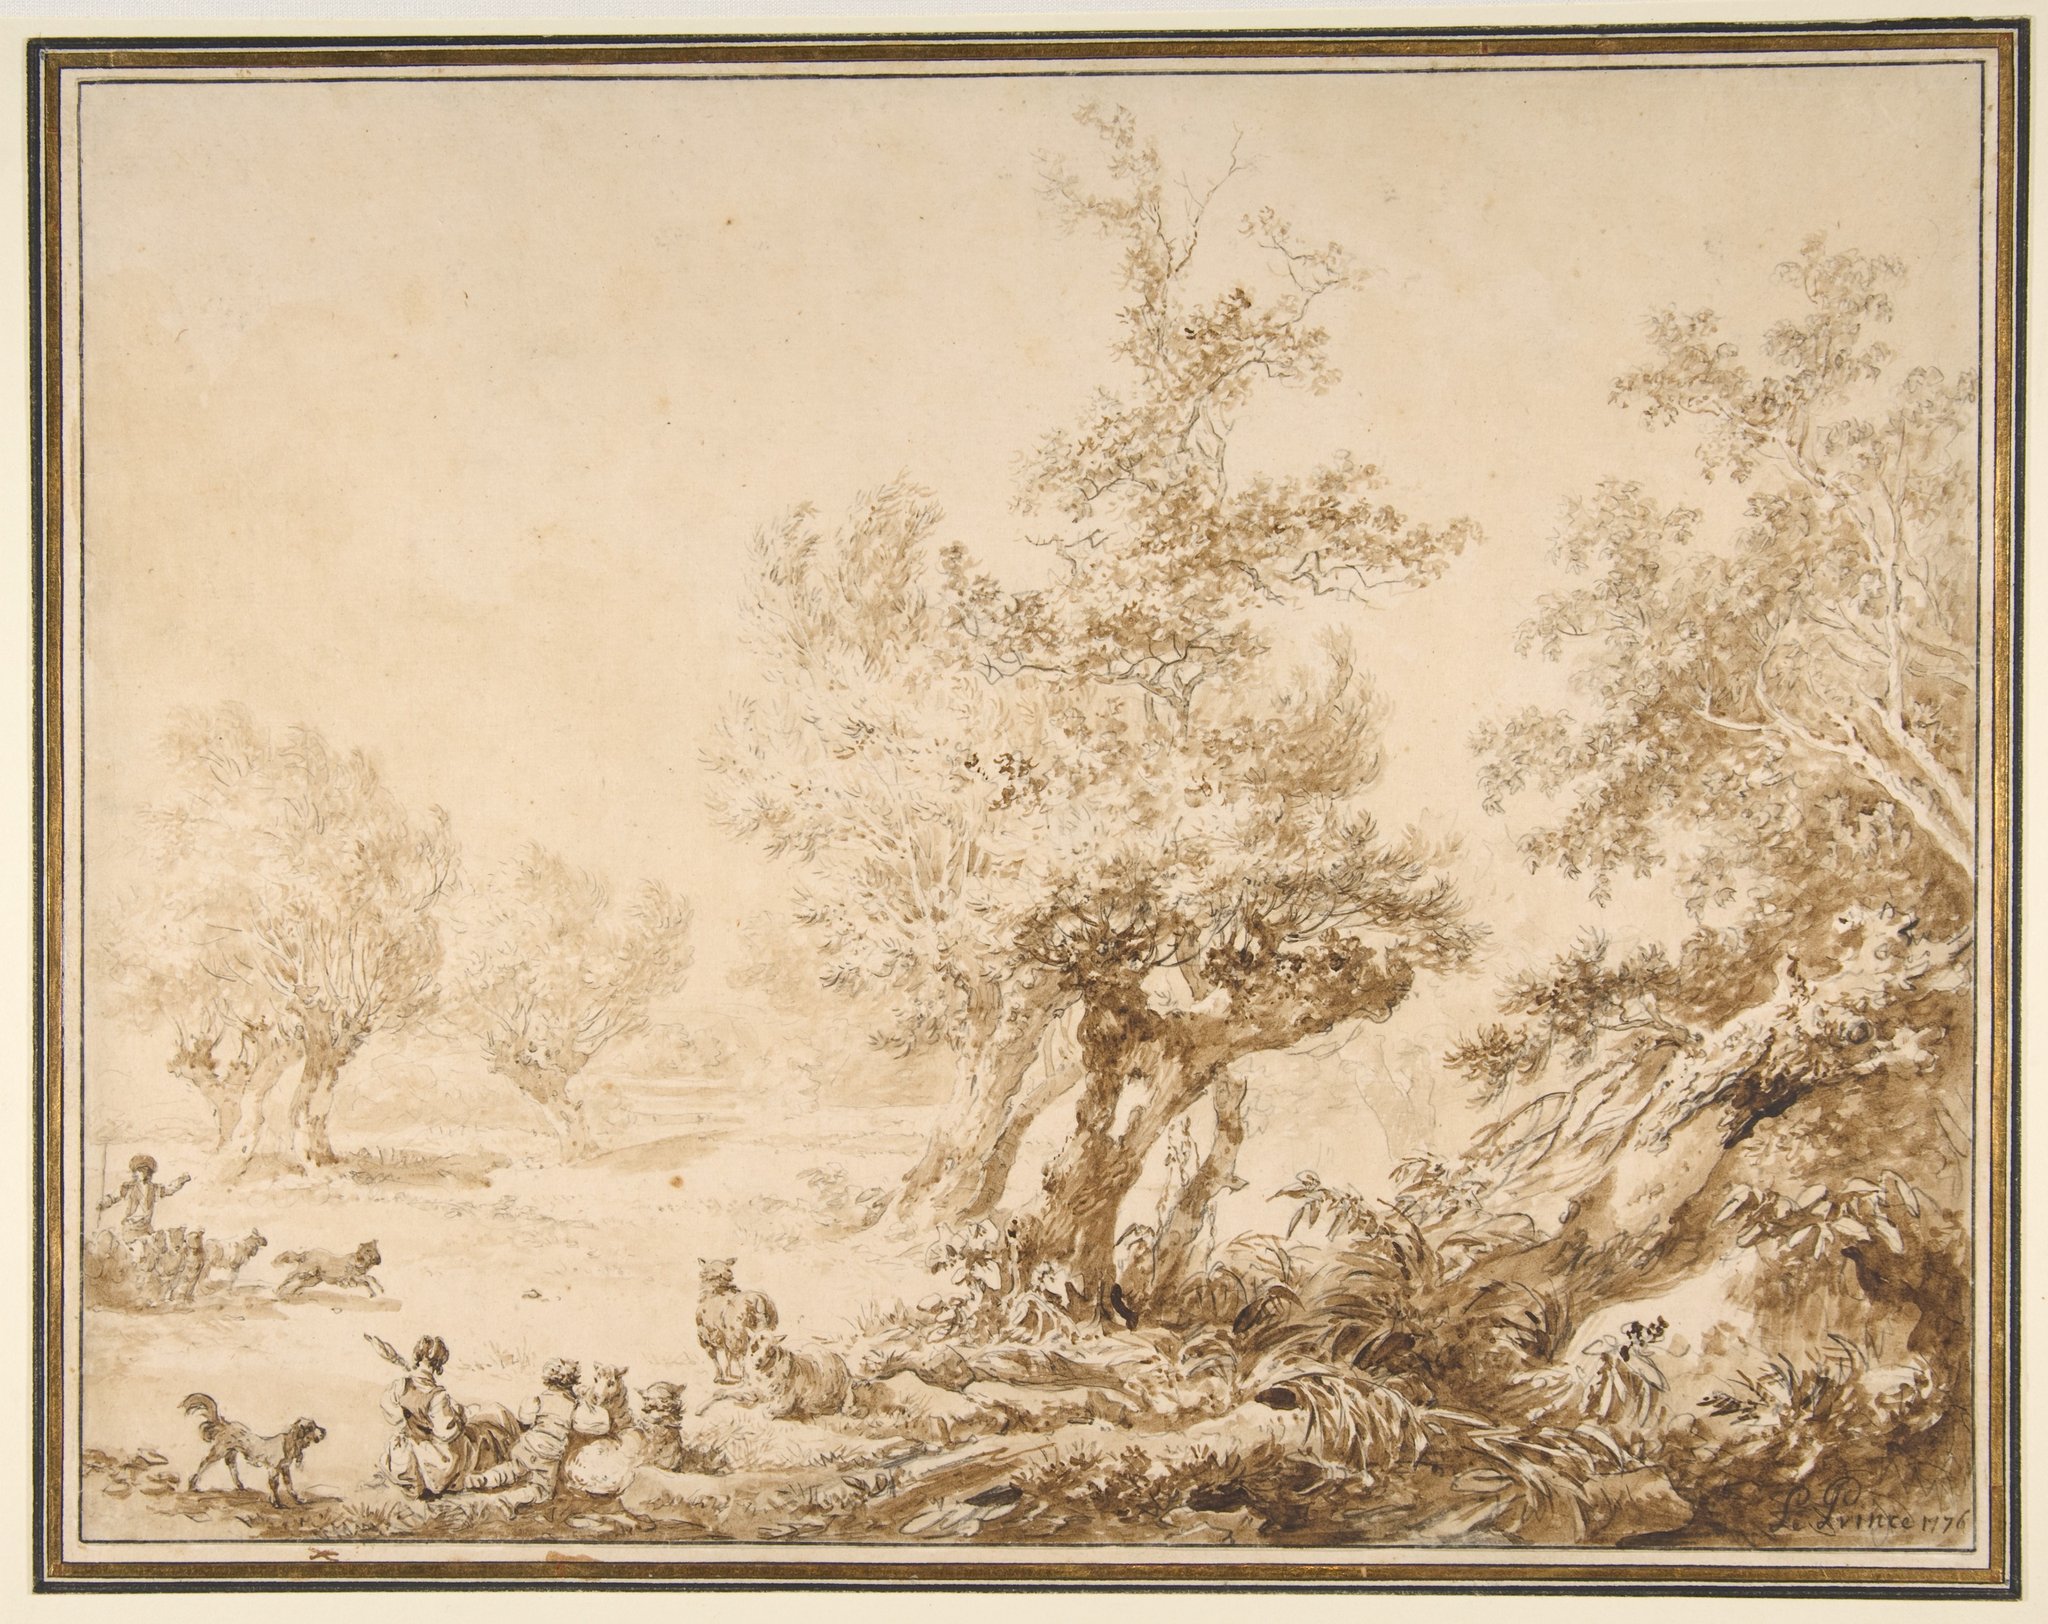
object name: drawing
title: Shepherd with His Flock in a Clearing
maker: jean-baptiste le prince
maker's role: artist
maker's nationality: french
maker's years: 1734-1781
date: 1776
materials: chalk, ink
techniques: brush, pen, wash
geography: france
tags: animals,trees,shepherds